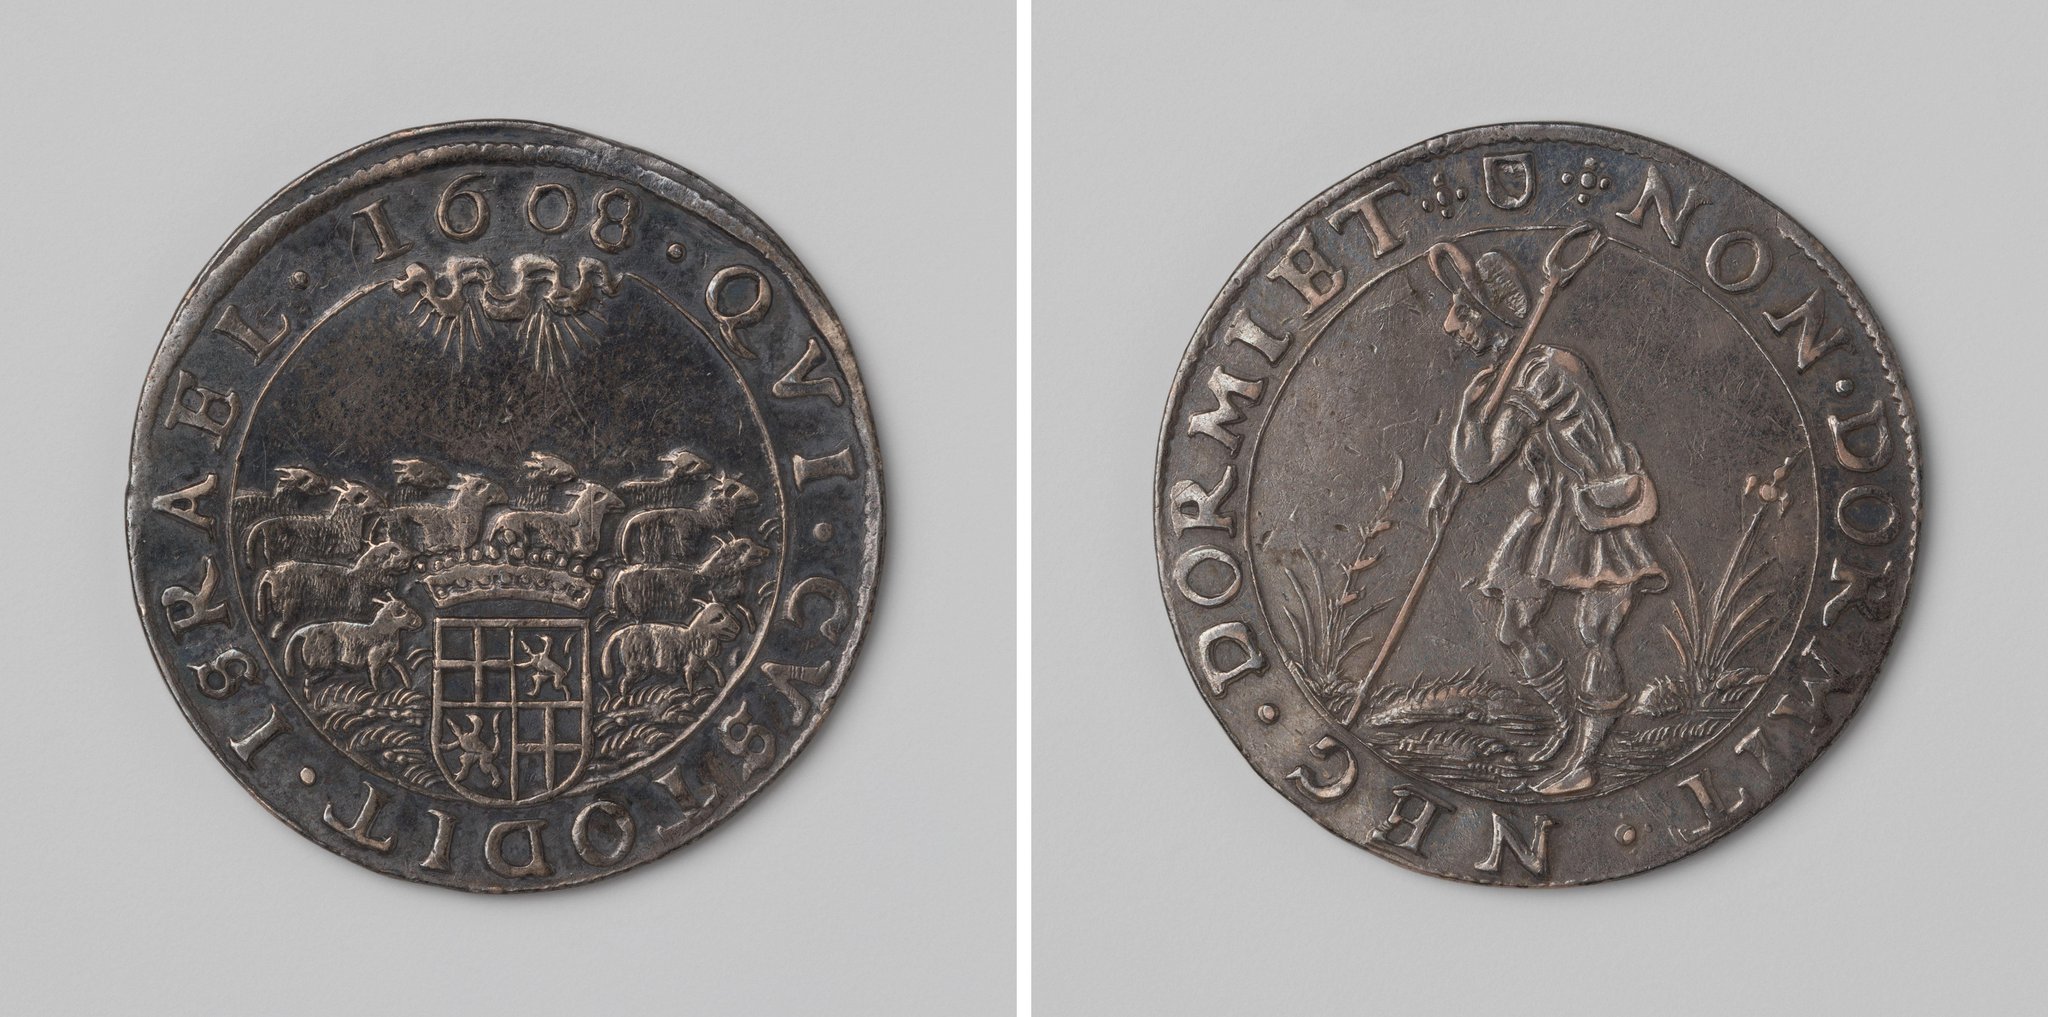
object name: jeton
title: Aanvaarding van de voorstellen voor een bestand tussen de Republiek en Spanje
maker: Anonymous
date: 1608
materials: silver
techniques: striking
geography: utrecht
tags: utrecht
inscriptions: circumscription: ‘QVI CVSTODIT ISRAEL 1608’, circumscription: ‘NON DORMIT NEC DORMIET’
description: Zilveren penning. Voorzijde: schaapskudde onder stralende wolk; daarvoor: gekroond wapenschild binnen omschrift. Keerzijde: herder in weide, rustend op zijn staf binnen omschrift.